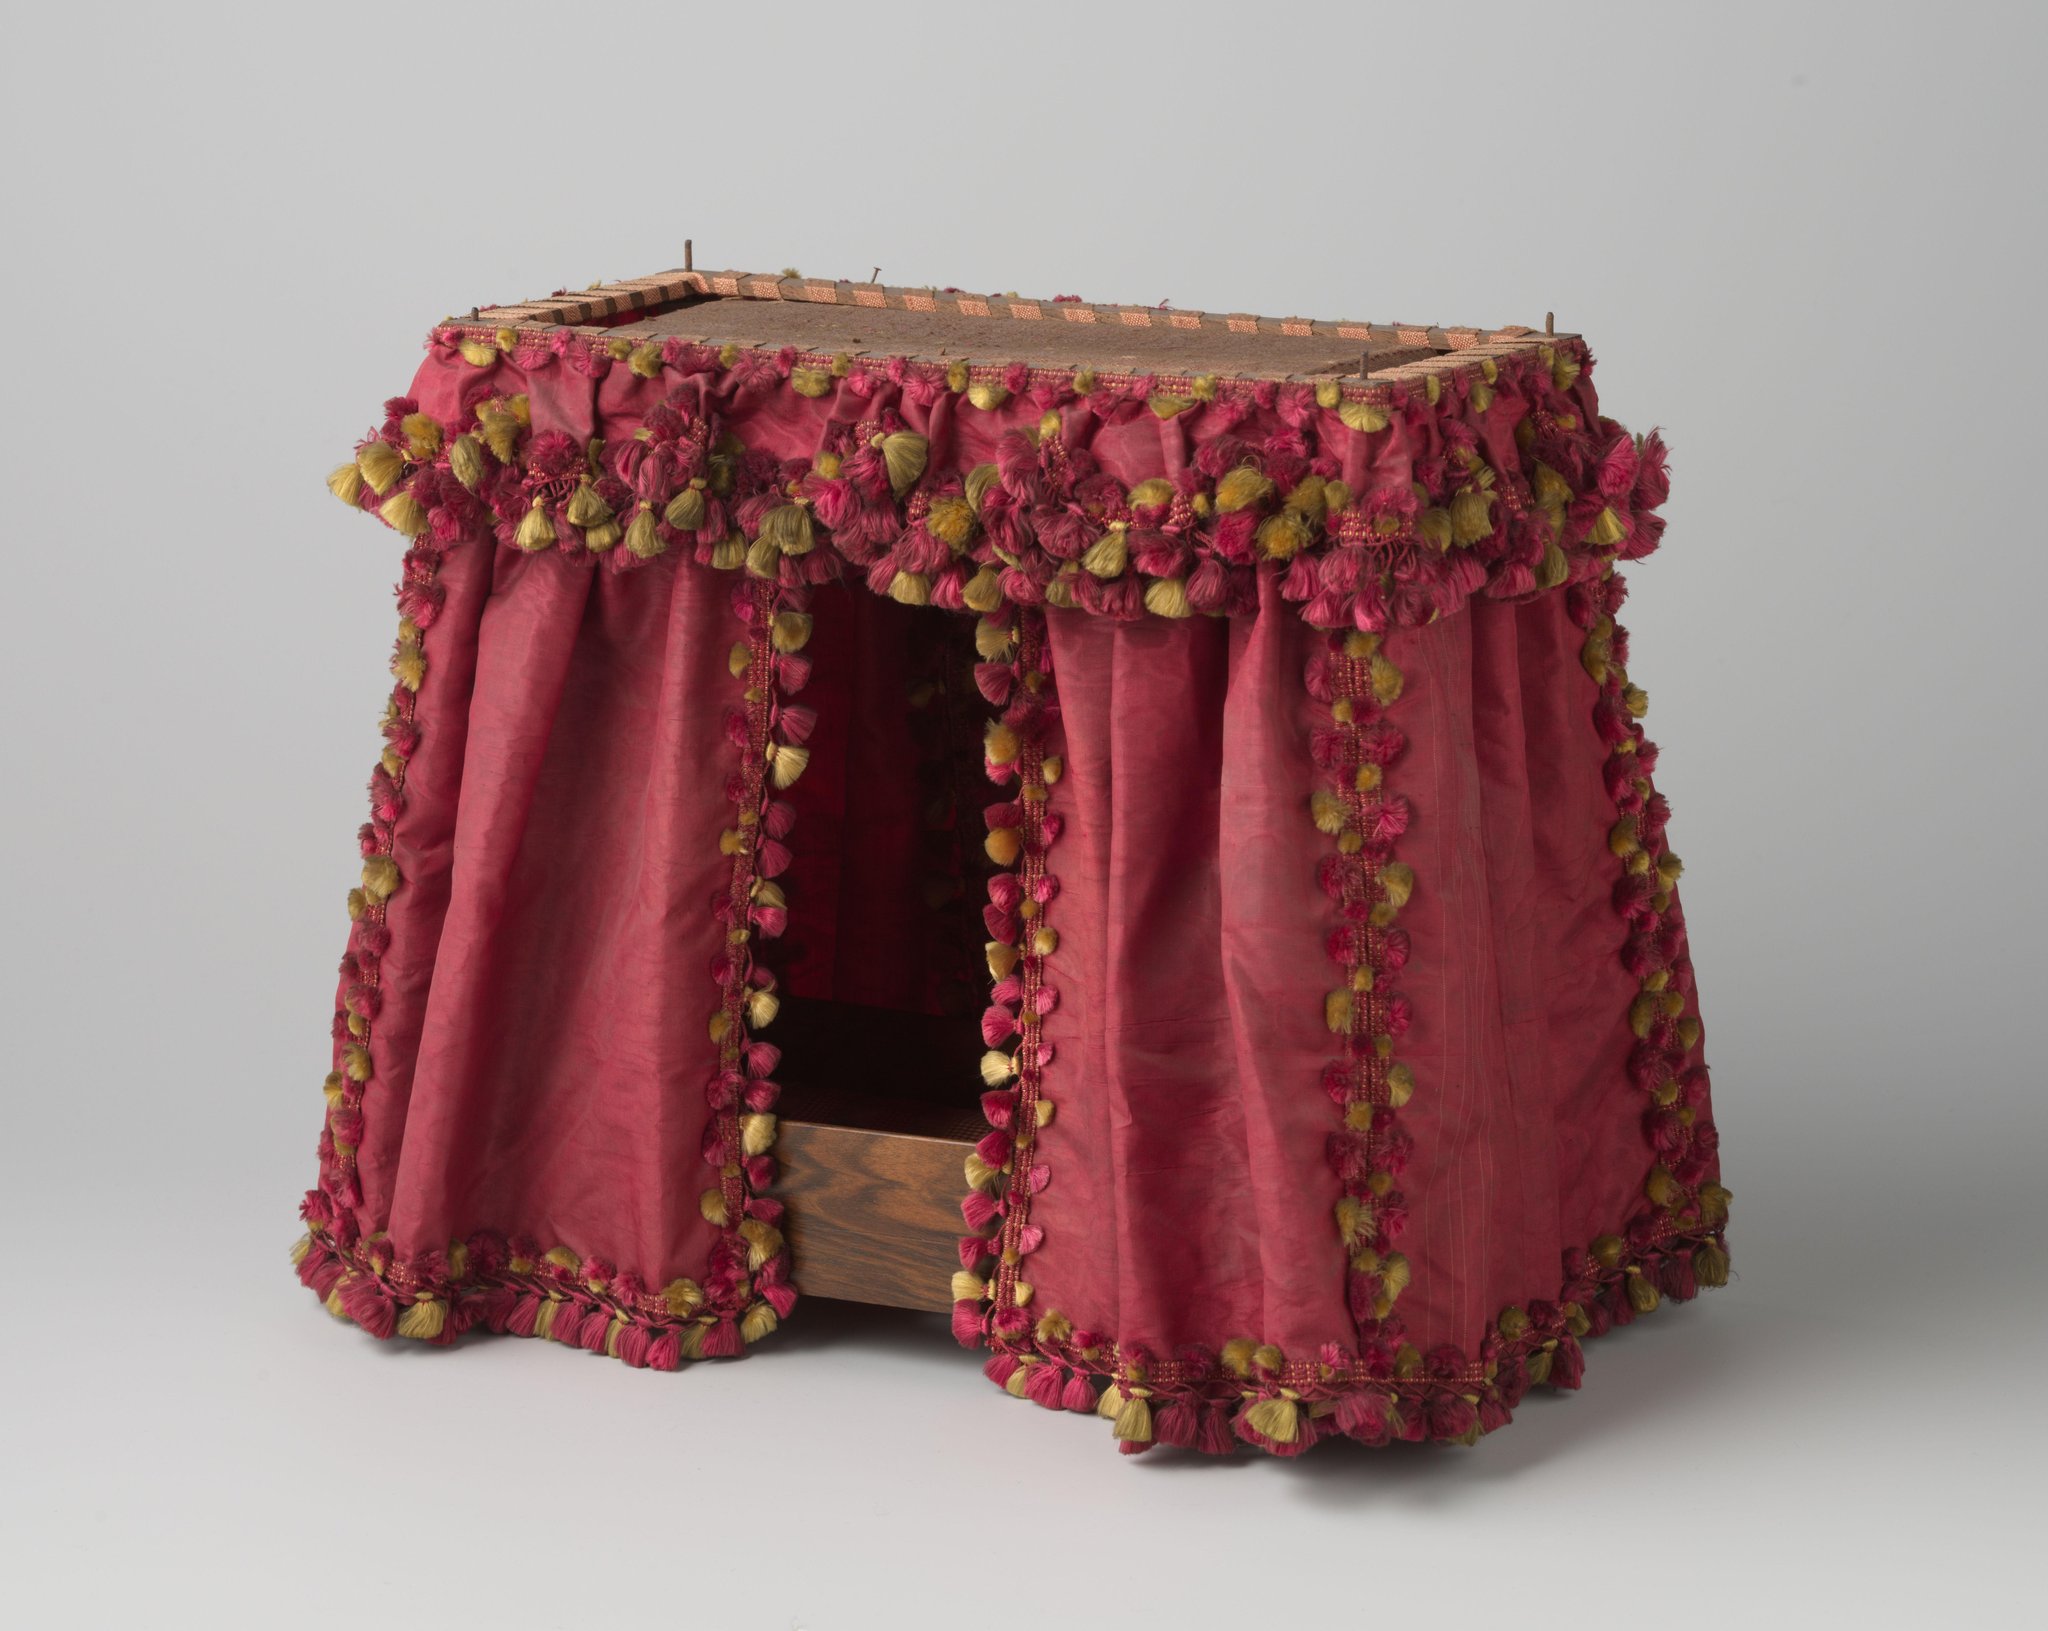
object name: canopy bed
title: Hemelbed vervaardigd van notenhout, volledig opgetuigd met gordijnen en vallen van zijde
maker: Anonymous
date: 1690-1710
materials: brass, iron, jute, linen, wood, silk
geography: amsterdam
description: Hemelbed, vervaardigd van notenhout, volledig opgetuigd met gordijnen en vallen van zijde. Het bed bestaat uit een houten bak met verhoogd hoofdeinde, rustend op bolpoten, waarbij een constructie geimiteerd is met valse scharnieren, alsof de twee lange zijden naar beneden geklapt kunnen worden. In de bak ligt een losse bodem, bestaande uit een eiken raamwerk met rood wit geblokte singelbanden omwonden. De vierkante hoekstijlen met imitatie ledikant bouten, lopen door in vier dubbel getorste bedstijlen, waarop op vier ijzeren pinnen de hemel en het raamwerk met de buitenste vallen rusten. tussen de stijlen zijn vier roeden aangebracht waaraan drie gordijnen van rode moiré zijde hangen, afgezet met passement met gele en rode kwasten. De verhoogde hemel is aan de binnenzijde bekleed met geel-roze changeant zijde, afgezet met dito passement. Aan de hemel zijn aan het hoofdeinde twee gele gordijnen bevestigd, die oorspronkelijk schuin zijn opgenomen, met een koord met kwasten rond de stijlen. De binnen vallen zijn vast aan de hemel bevestigd; aan drie kanten zijn zij vervaardigd van rode zijde, één kortere val van gele zijde (in de lengte aan de kant van de alkoof opening). Boven de hemel zijn op de pinnen vier blokjes geschoven (zogenaamde "spacer") waarop een met band omwikkeld raamwerk, waaraan de golvend opgenomen buitenvallen zijn vastgezet.